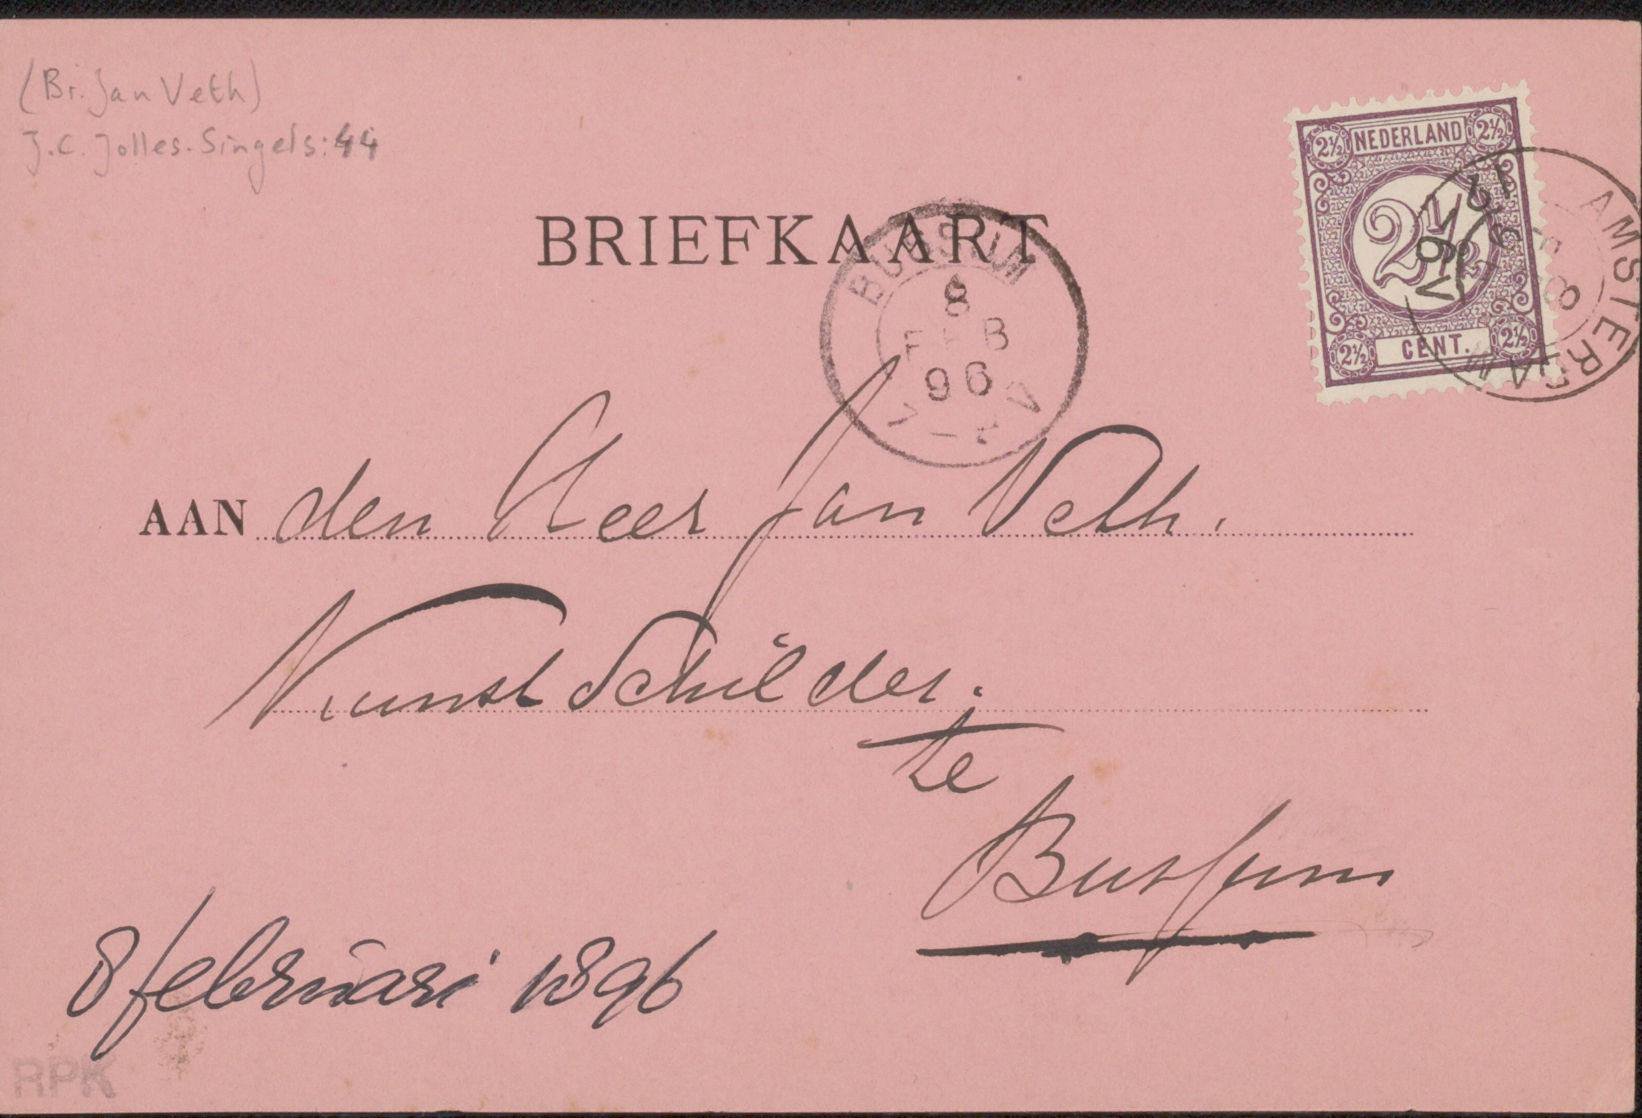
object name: postcard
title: Briefkaart aan Jan Veth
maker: jacoba cornelia jolles-singels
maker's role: schrijver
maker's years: 1847-1901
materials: cardboard, ink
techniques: pen, writing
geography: amsterdam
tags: the hague, painter, print maker, draughtsman, johannes bosboom, designer, jan veth, utrecht, albert neuhuys (1844-1914), den bosch, antoon derkinderen, exhibition ~ art, historical persons (portraits and scenes from the life)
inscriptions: collector's mark: ‘RPK’